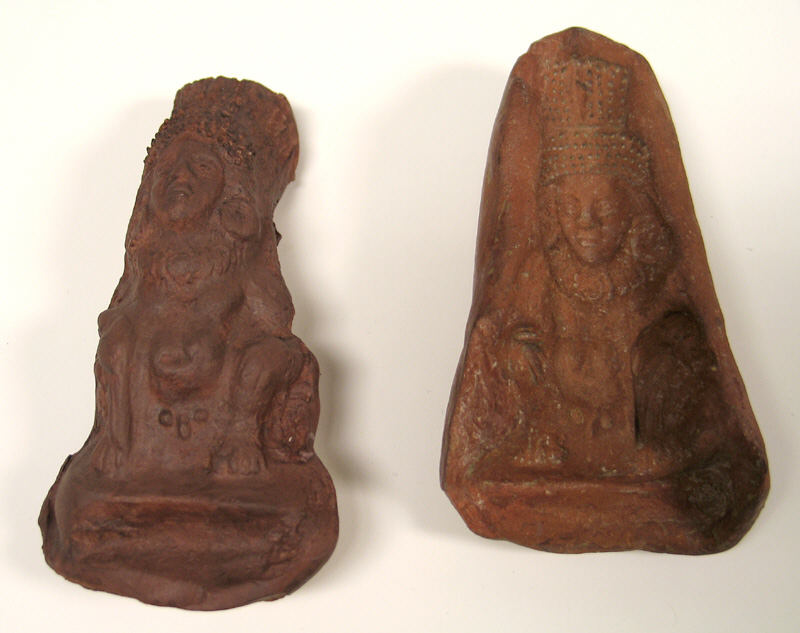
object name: mold and impression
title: Mold and Impression for a Crouching Demon Dwarf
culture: indian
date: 100 BCE-100 CE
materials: terracotta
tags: shunga,demons